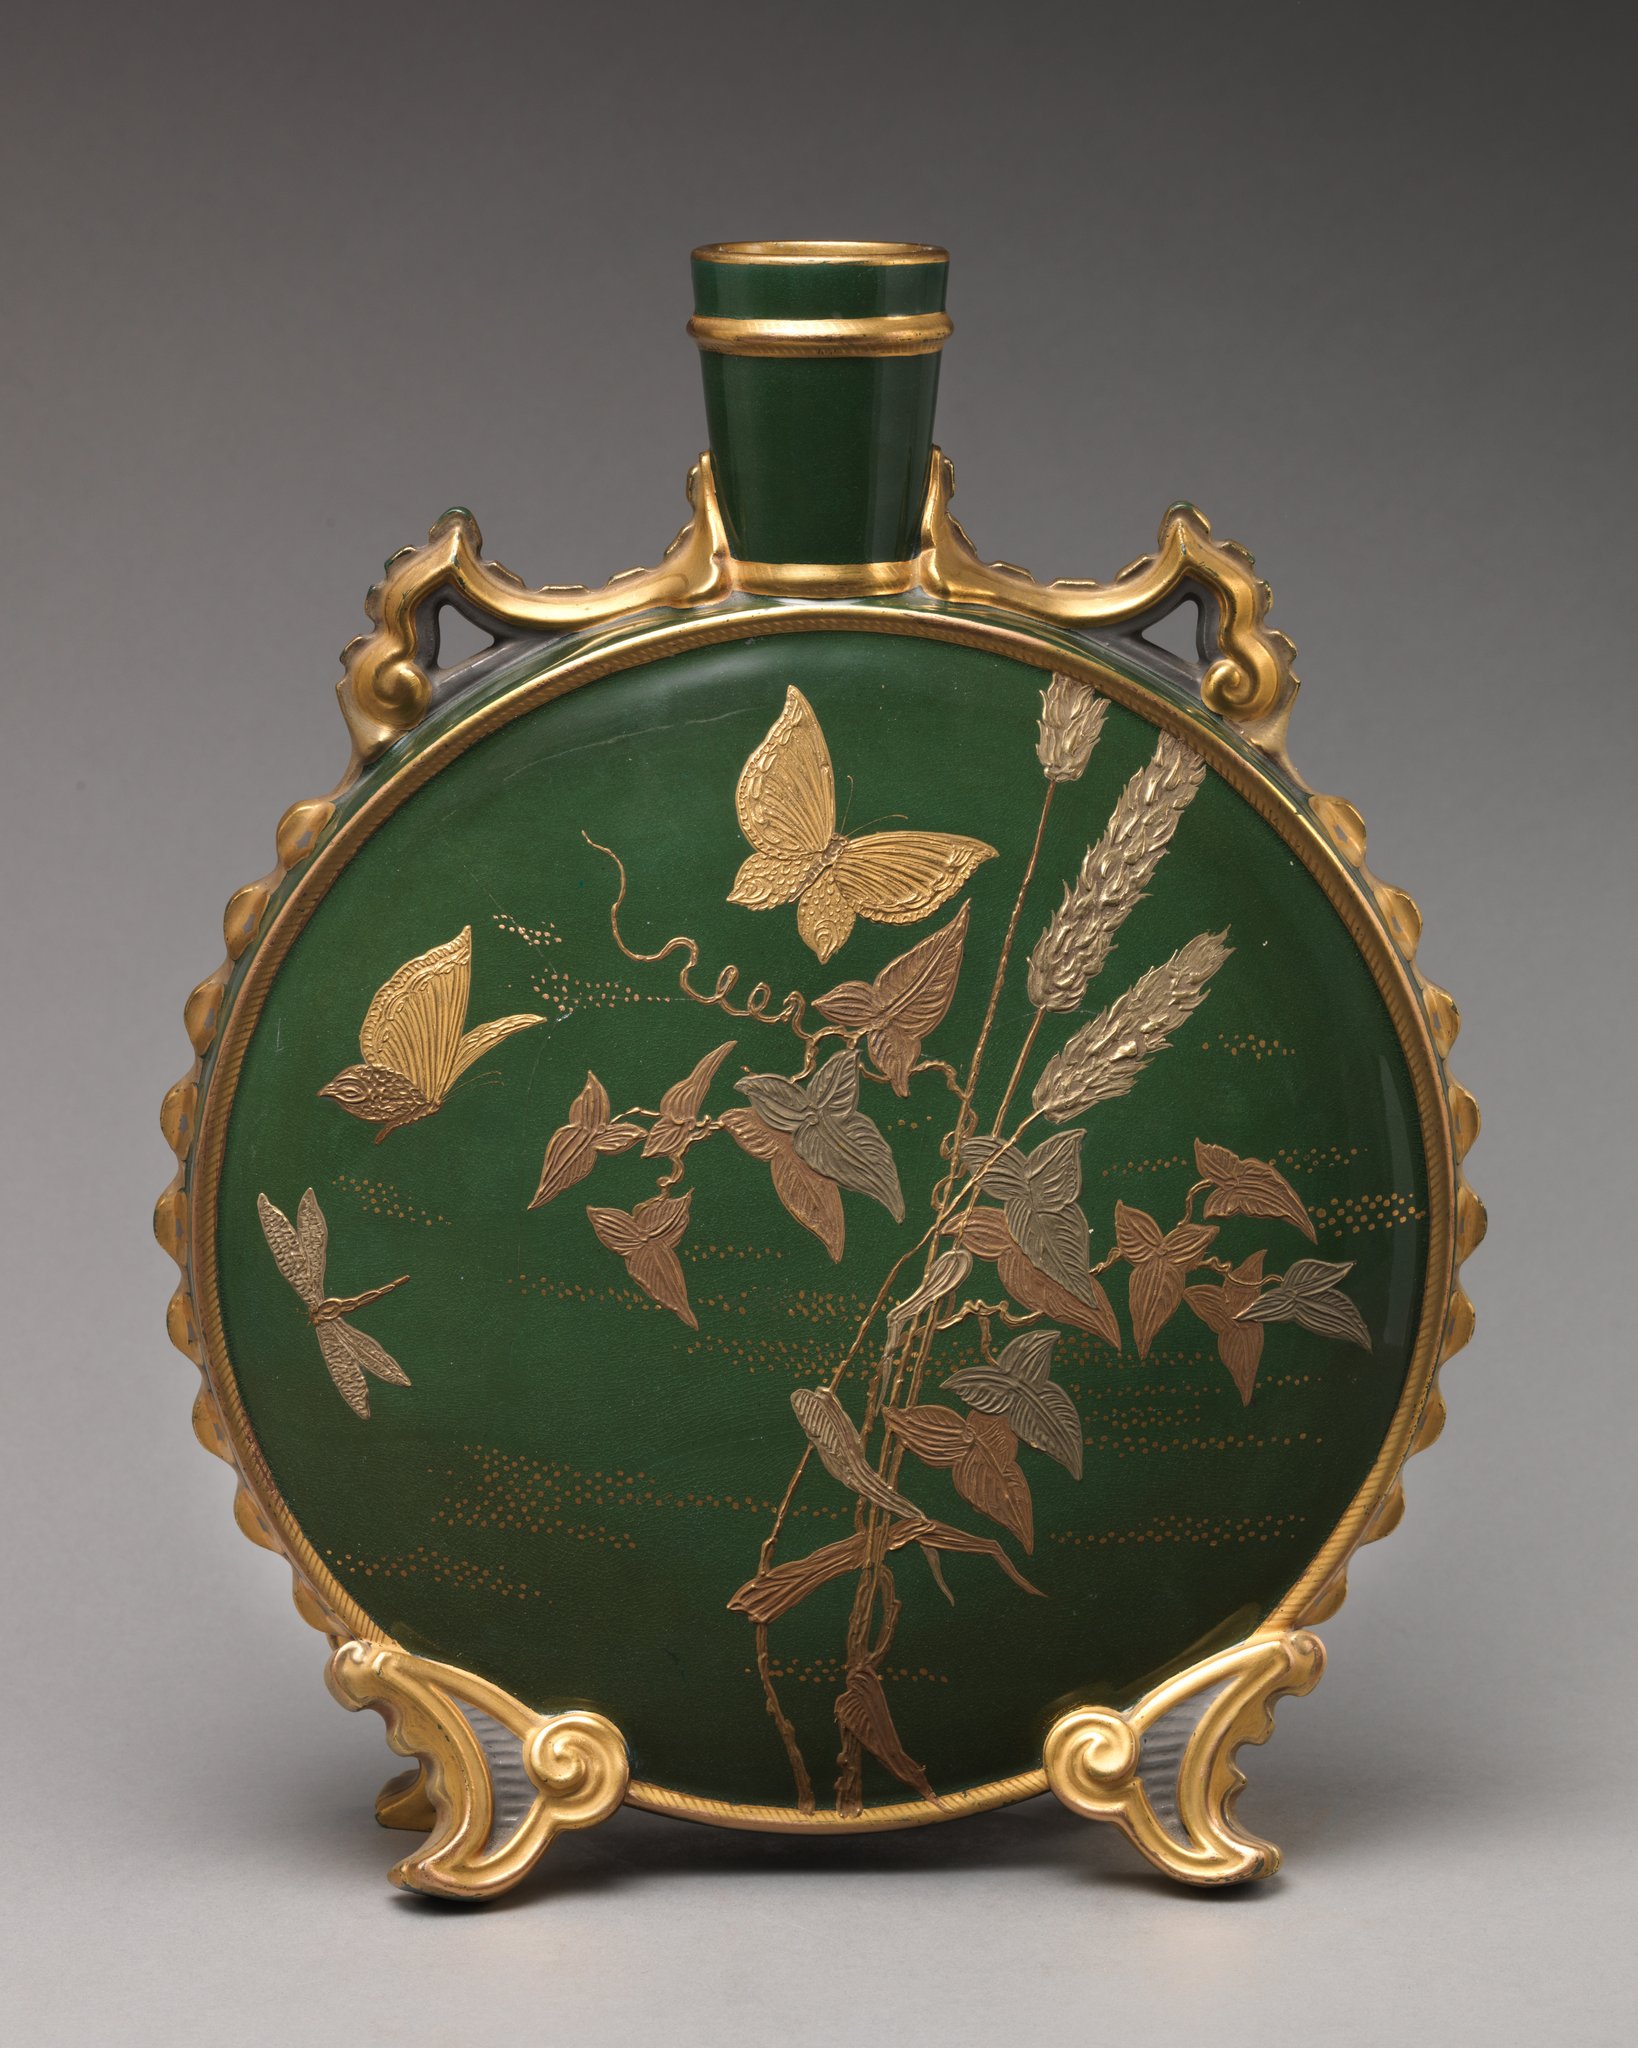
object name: moon flask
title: Moon flask with gold butterfly and wheat motifs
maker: worcester factory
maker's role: maker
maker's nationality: british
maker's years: 1751-2008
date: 1880-1889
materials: bone china